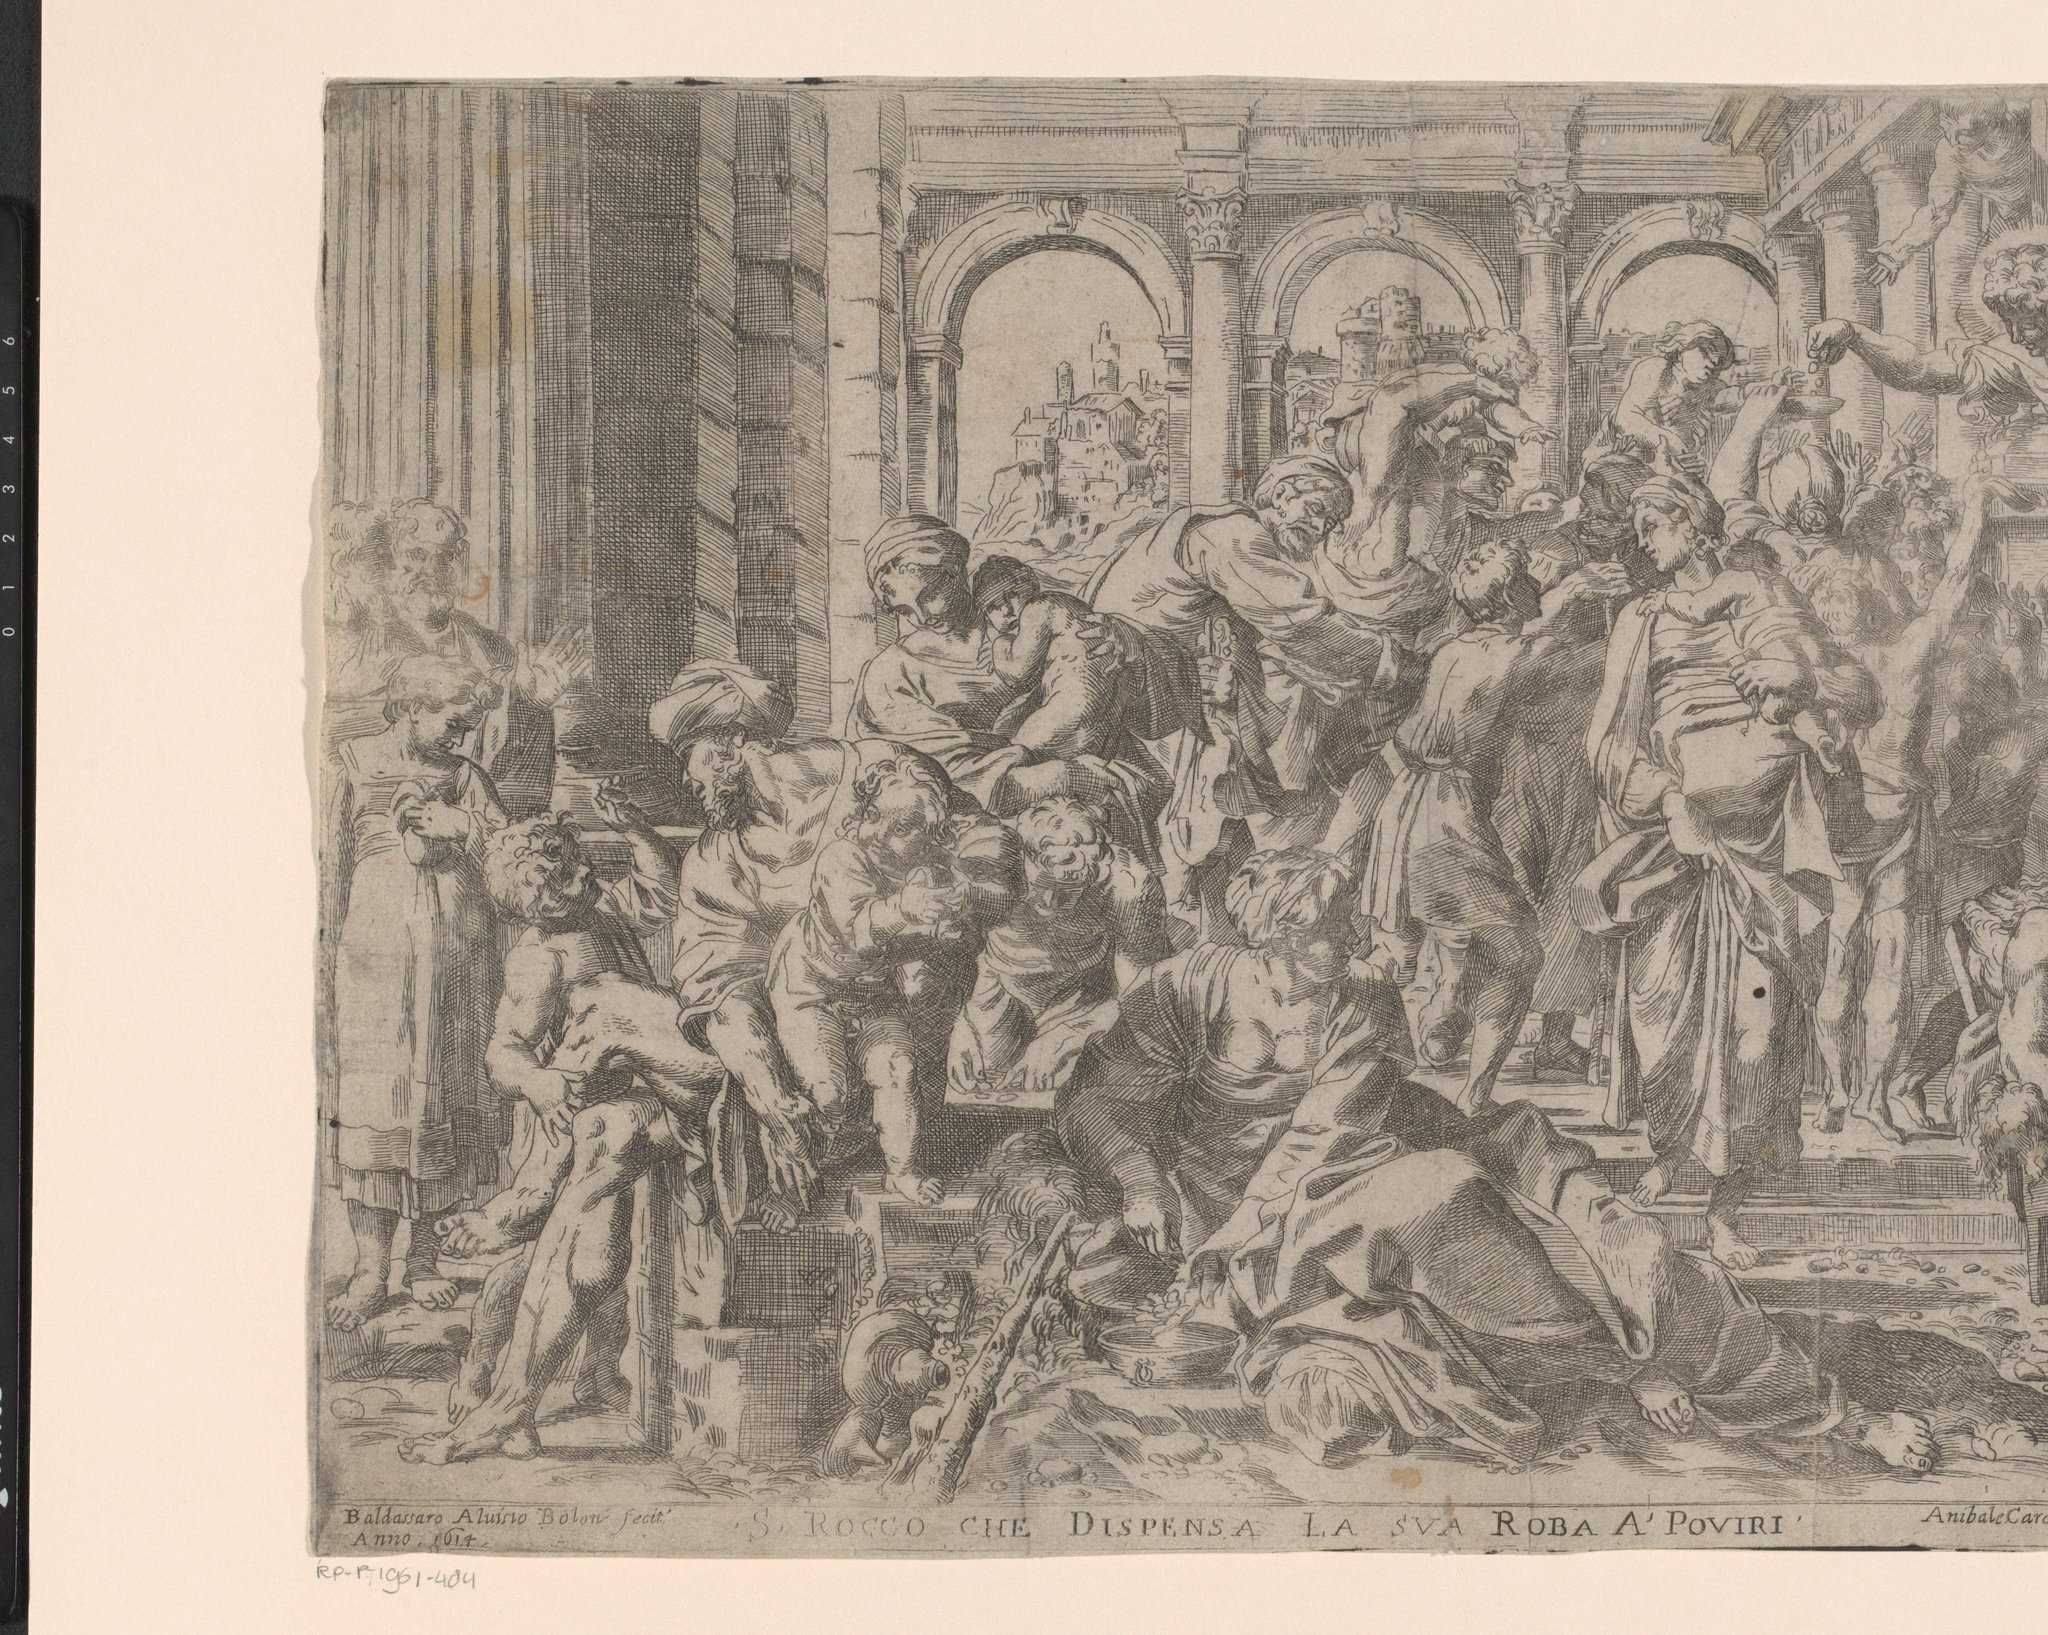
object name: print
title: De heilige Rochus deelt aalmoezen uit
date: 1614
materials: paper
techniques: etching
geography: bologna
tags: st. roch distributes his riches to the poor, and leaves on a pilgrimage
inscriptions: collector's mark: Lugt 2760, collector's mark: Lugt 2228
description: De heilige Rochus staand op een verhoging rechts. Hij deelt aanmoezen uit aan een menigte arme en zieke mensen op de trappen voor hem. Op de achtergrond drie bogen en een stadsgezicht.